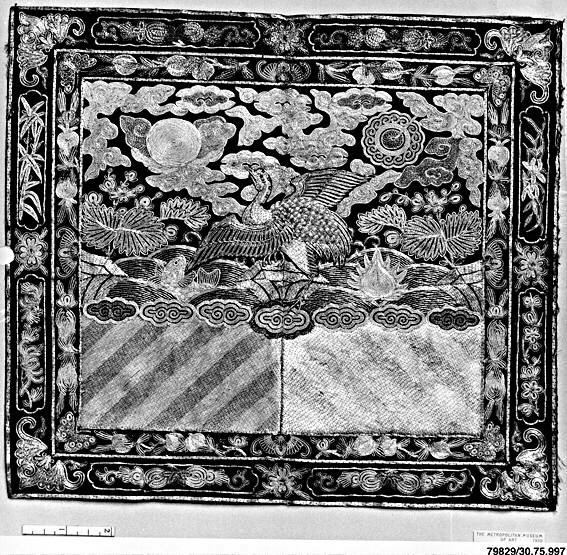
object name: rank badge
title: Rank Badge with Goose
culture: chinese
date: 1867-1900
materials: metal thread, silk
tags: bats,geese,fish